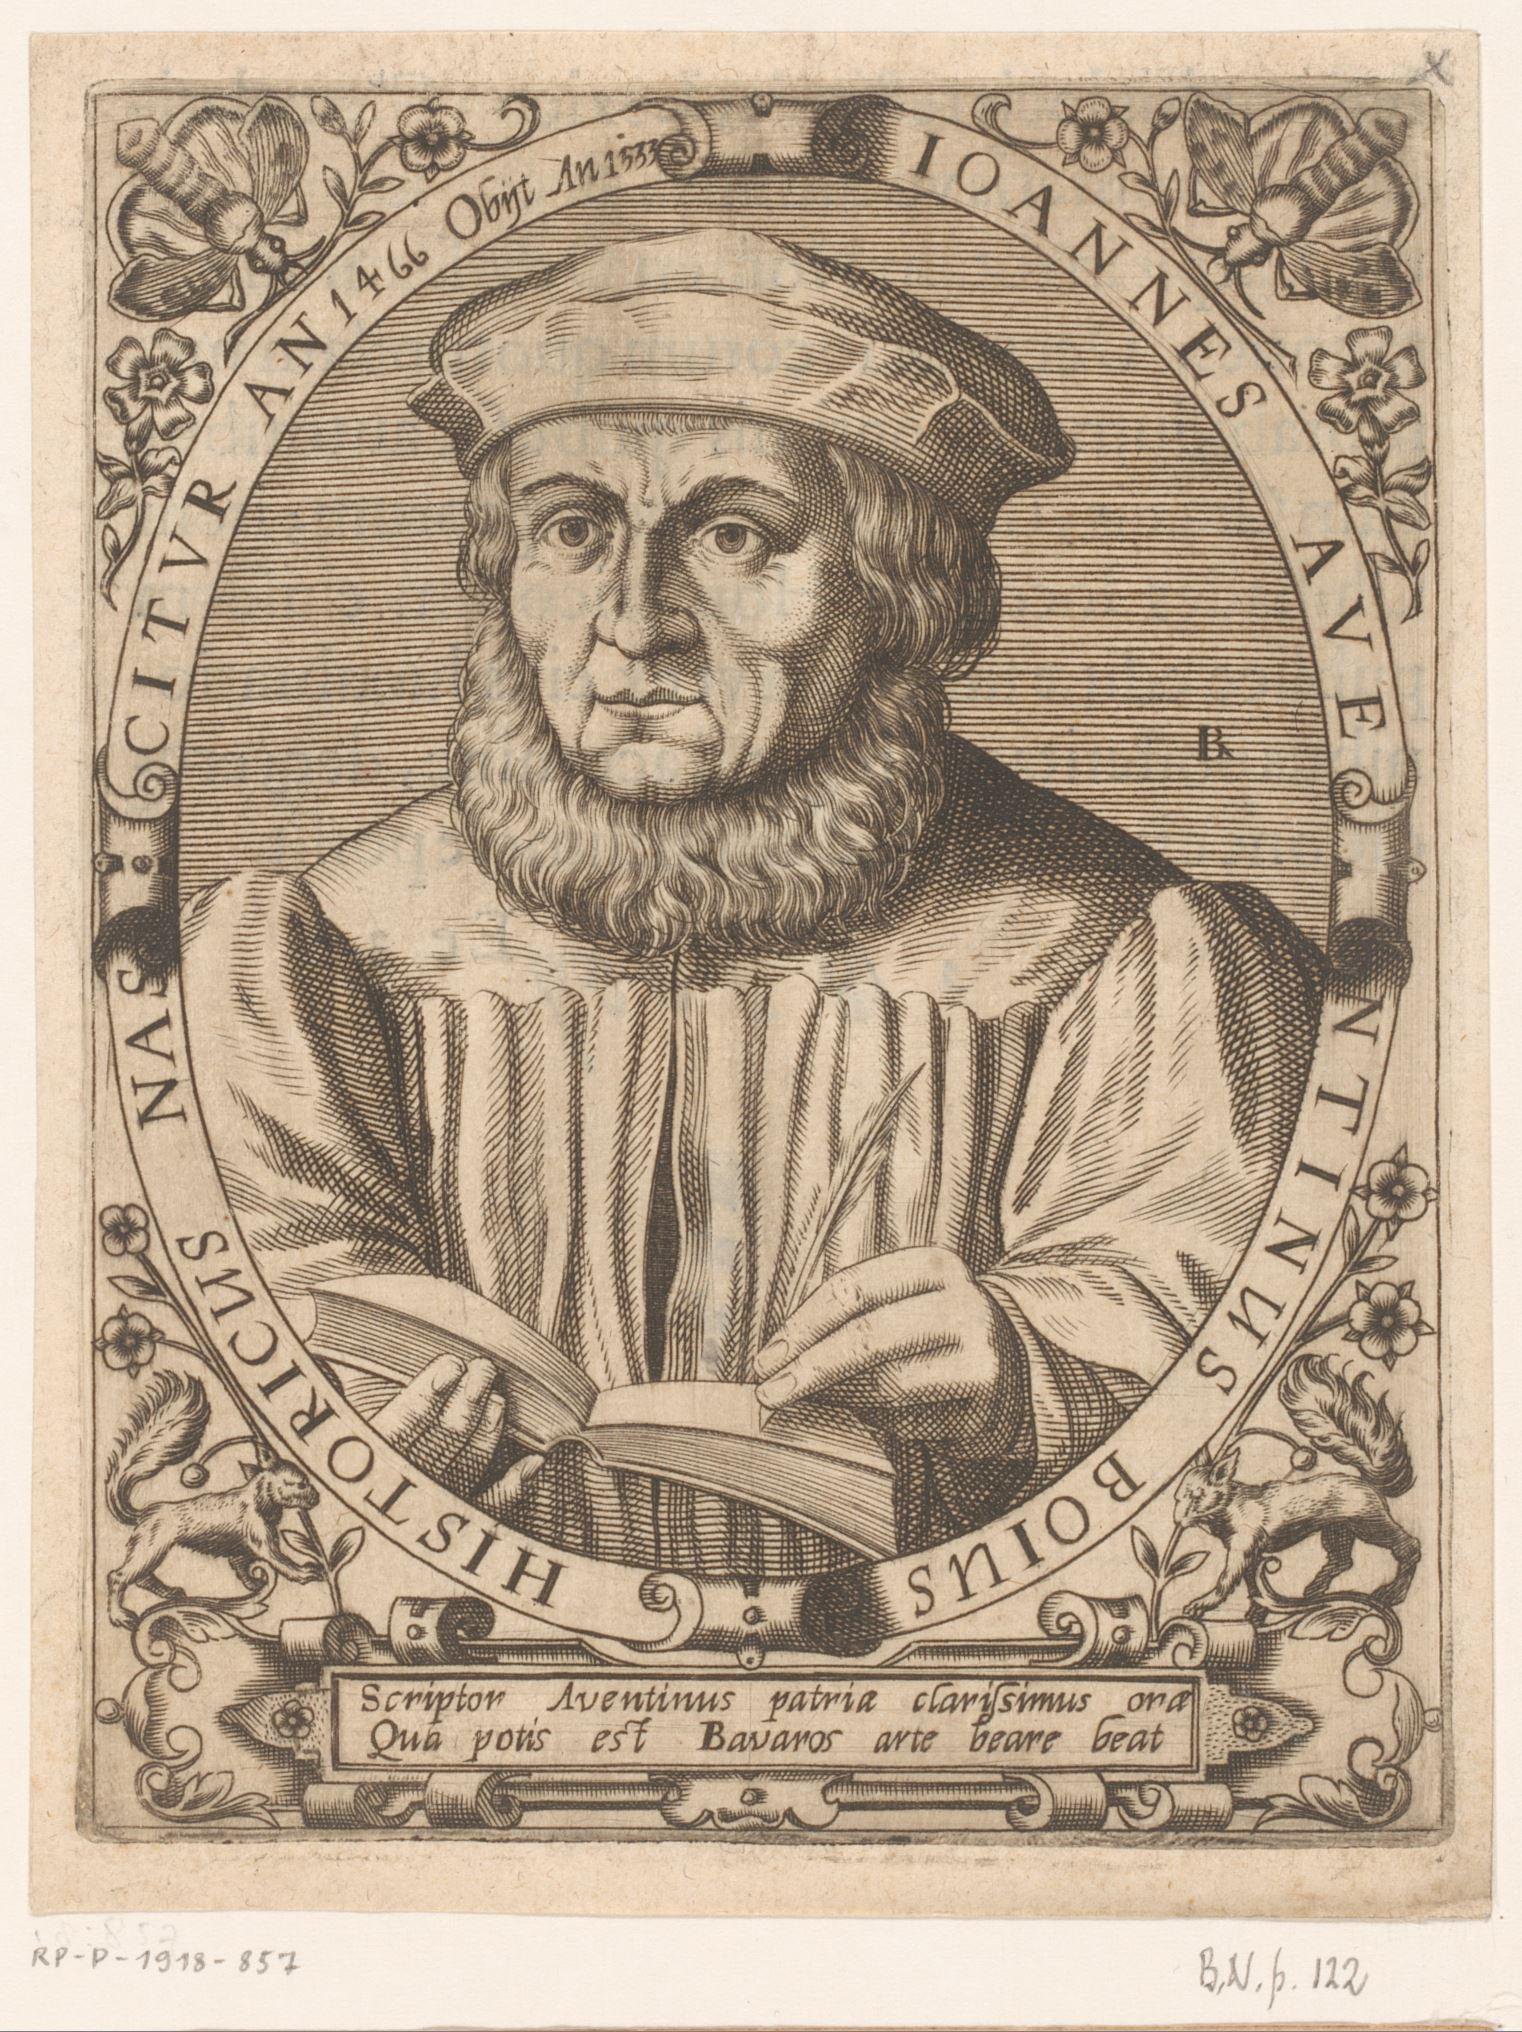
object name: print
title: Joannes Aventinus Boius historicus nascitur an 1466 Obiit An 1533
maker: robert boissard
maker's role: print maker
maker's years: 1570-1611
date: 1597-1599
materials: paper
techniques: engraving, letterpress printing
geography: france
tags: historical persons, book, rodents: squirrel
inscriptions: collector's mark: Lugt 2233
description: Prent uit: Boissard, Jean Jacques. Icones quinquaginta virorum illustrium doctrina & eruditione praestantium ad vivum effictae. Frankfurt am Main: s.n., 1597